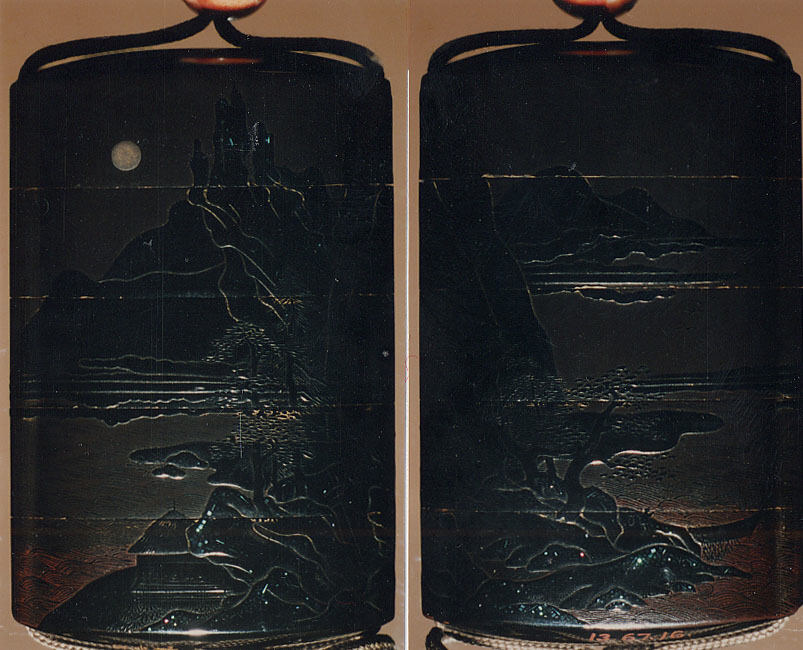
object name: inrō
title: Inrō with Chinese Landscape in Moonlight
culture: japanese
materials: wood, metal, mother of pearl, stone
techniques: carving, hiramakie, inlay, lacquer, maki-e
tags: moon,landscapes,trees